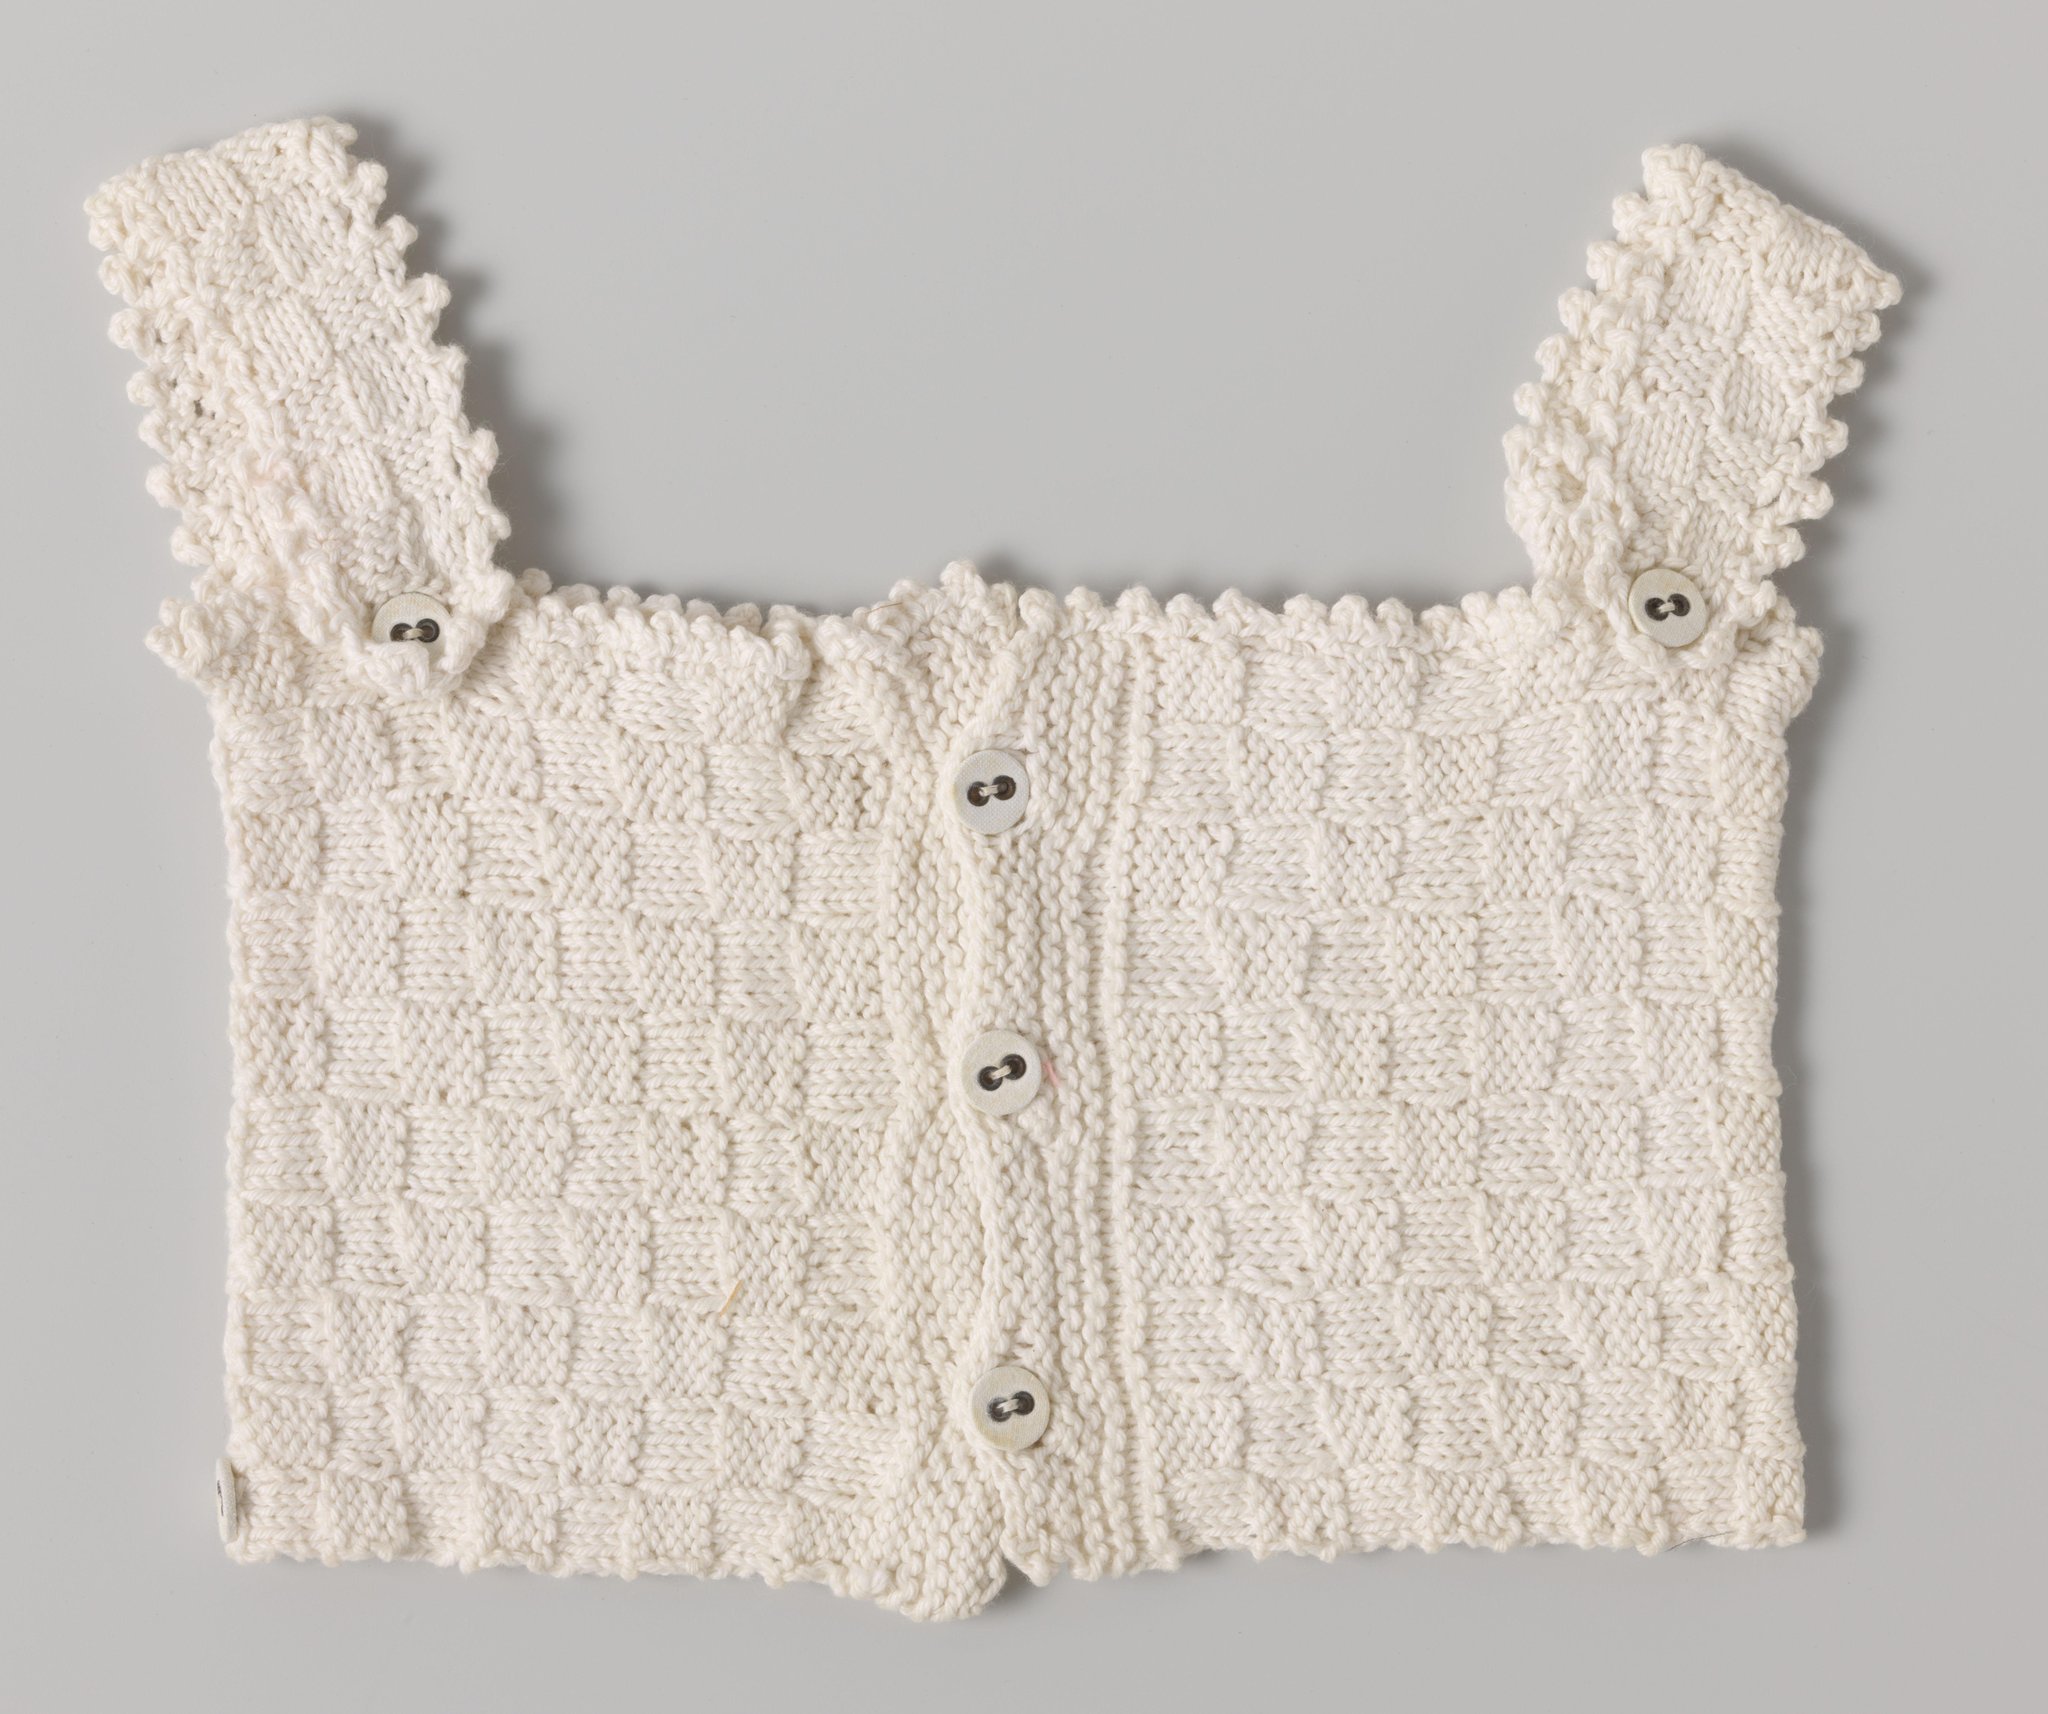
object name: corsage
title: Lijf van brei en/of haakwerk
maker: Anonymous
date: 1917-1920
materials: yarns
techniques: crochet, knitting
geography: amsterdam